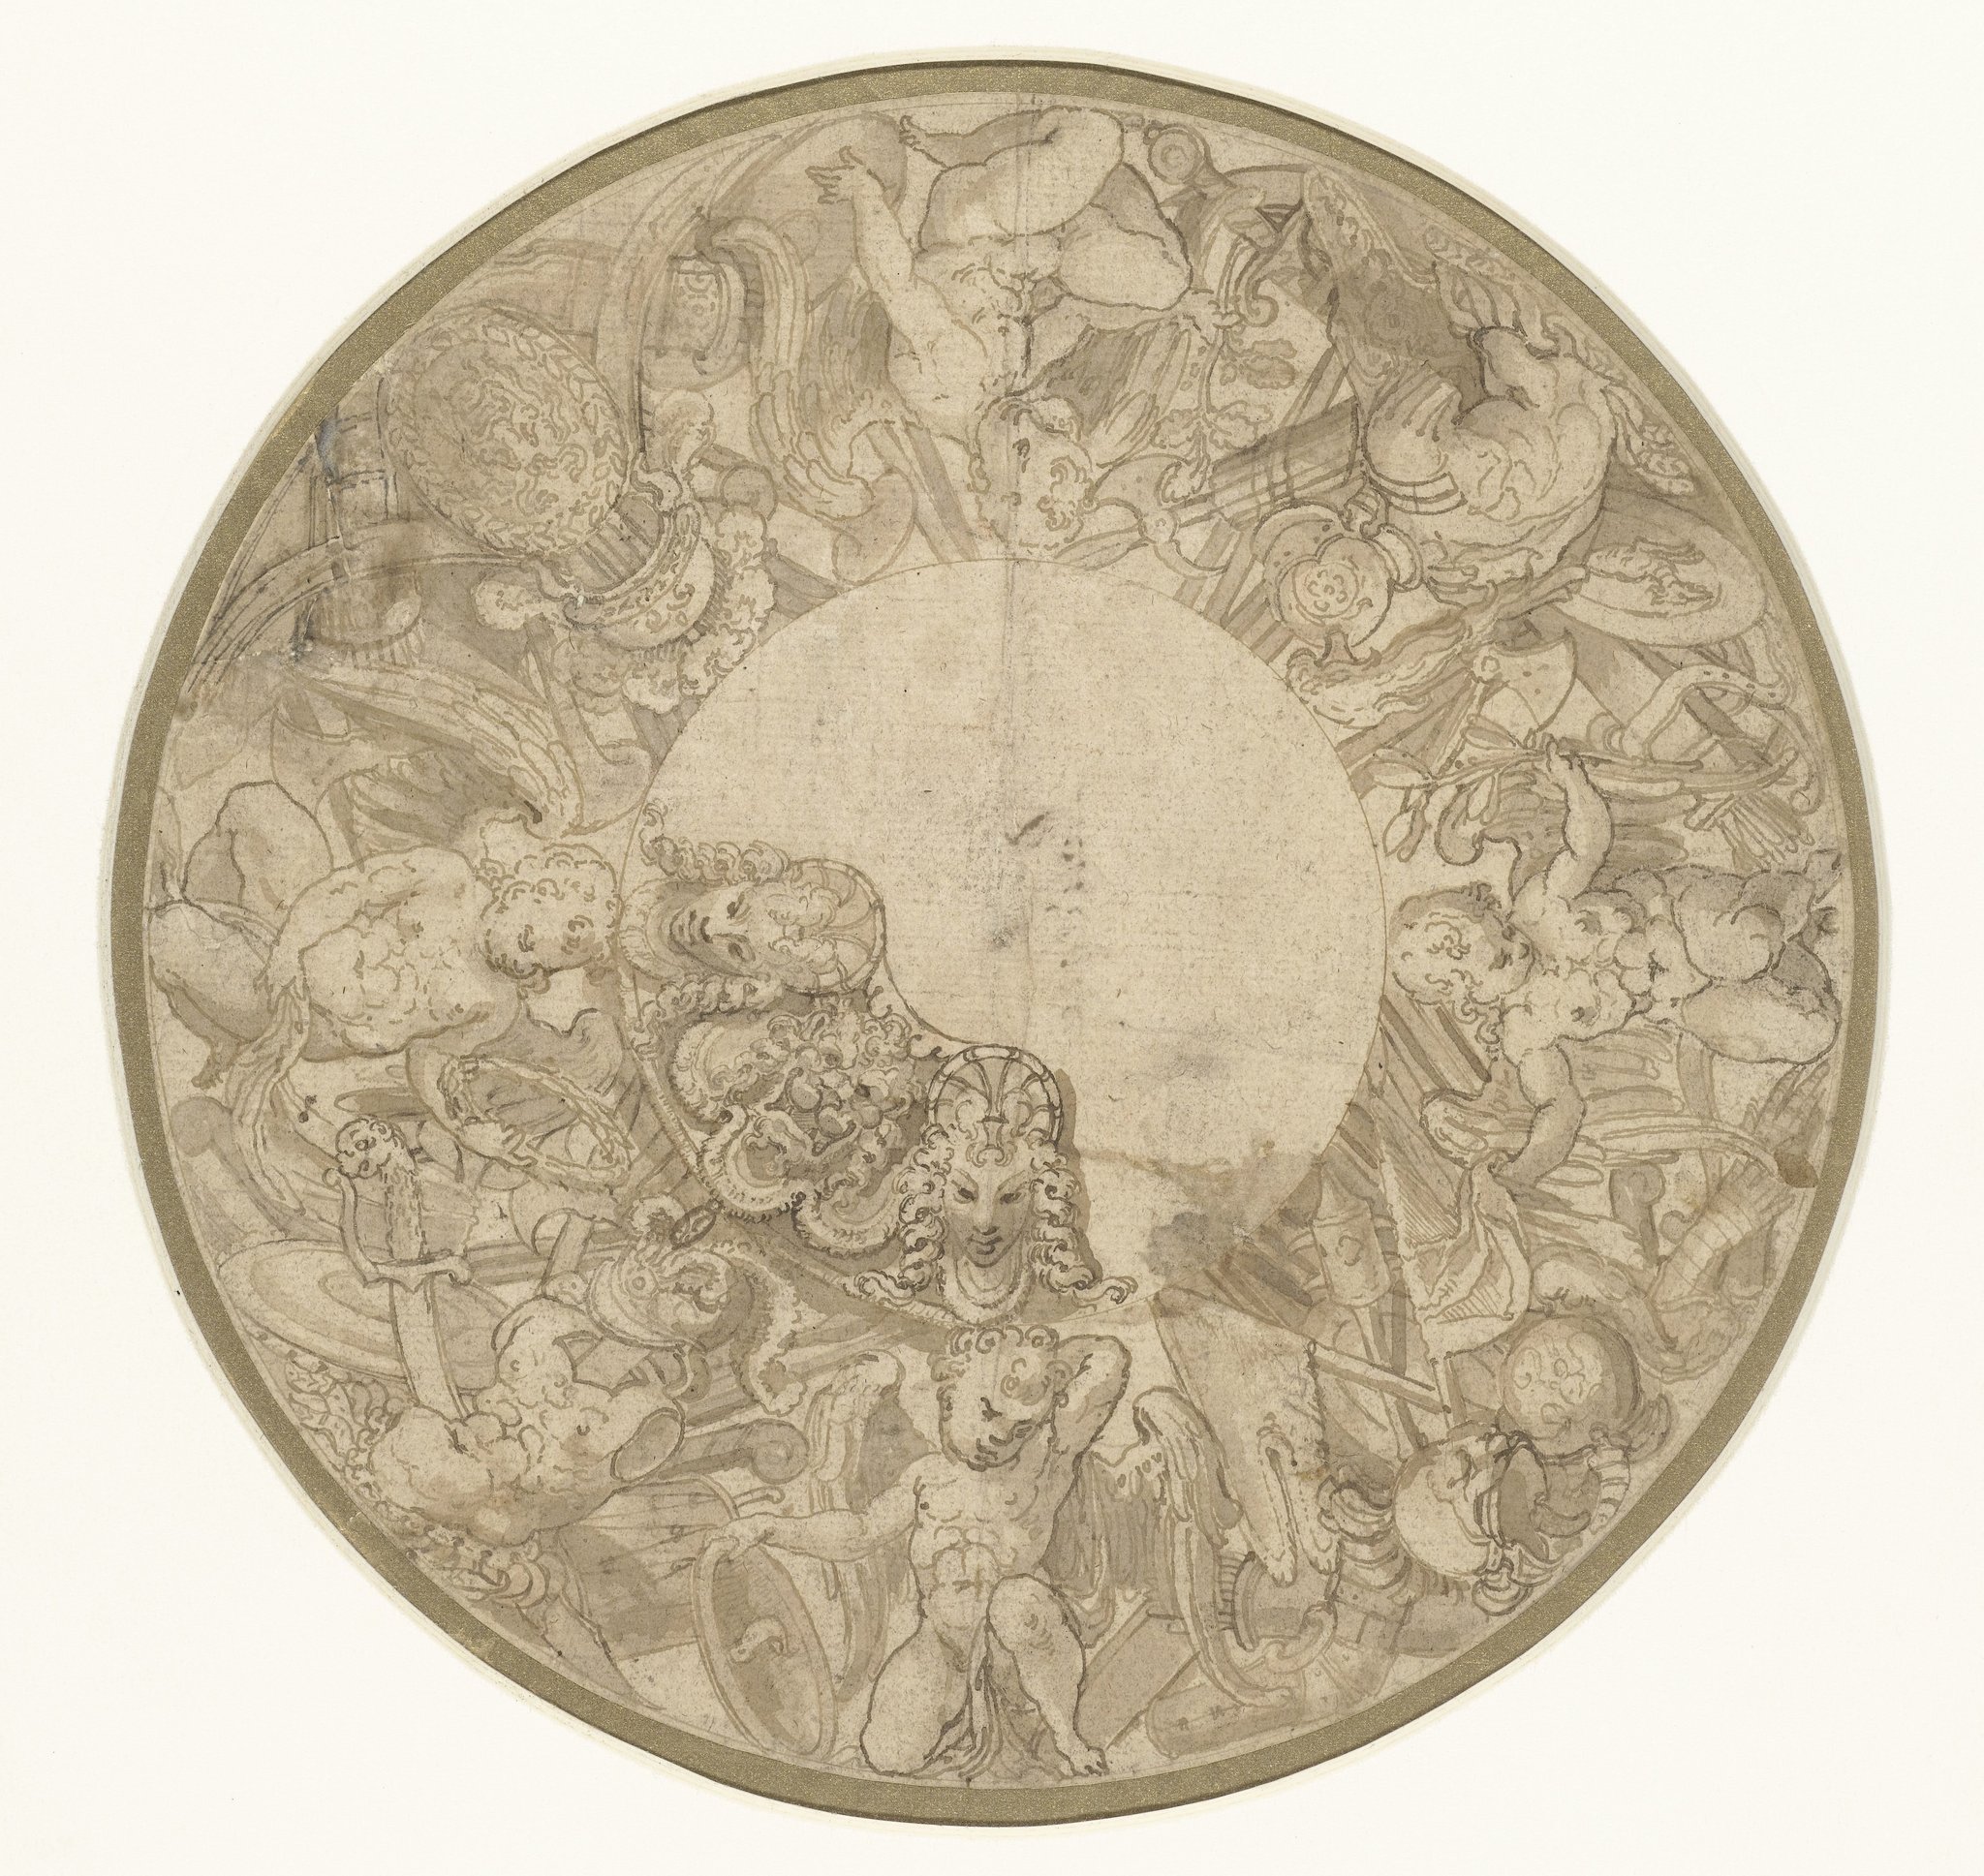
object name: design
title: Ontwerp voor de voet van een ronde pronkschaal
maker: perino del vaga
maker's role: draughtsman, painter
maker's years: 1501-1547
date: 1511-1547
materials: ink, paper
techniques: brush, pen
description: Ronde schaal met mascarons en putti temidden van oorlogstuig.